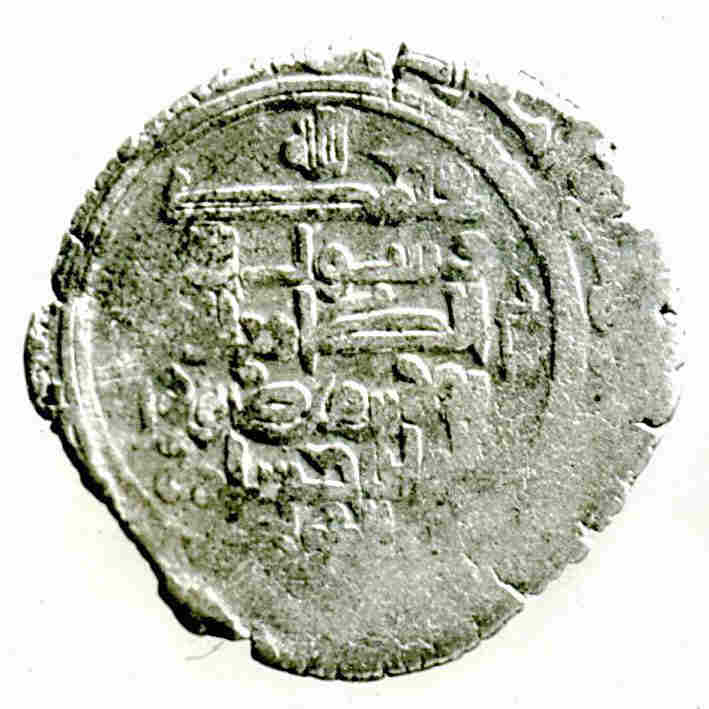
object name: coin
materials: silver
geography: iran